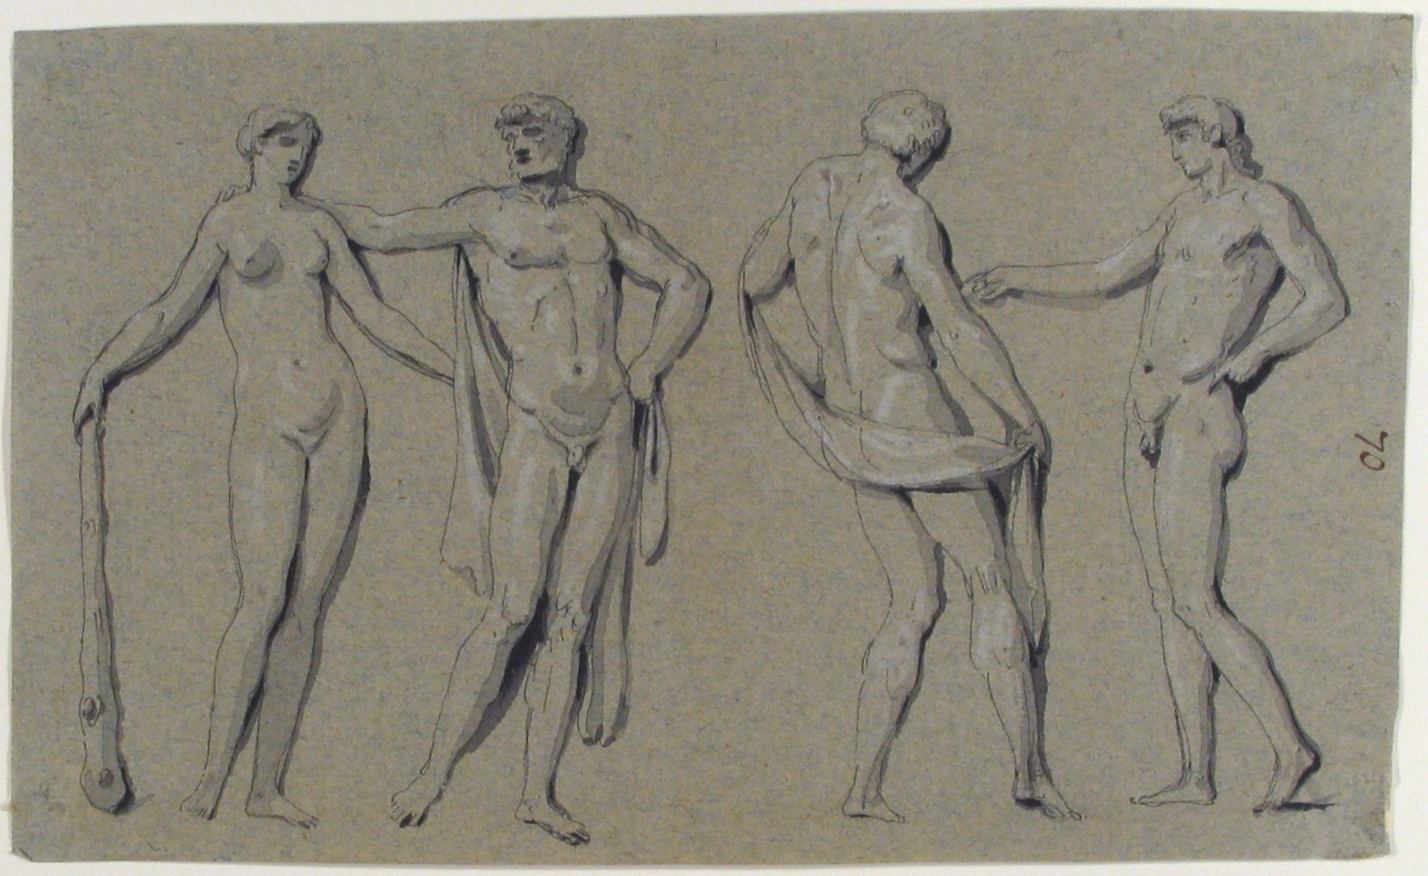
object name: drawing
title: Group of Nude Figures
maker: anonymous, french, 18th century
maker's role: artist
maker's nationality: french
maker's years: 1700-1800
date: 1701-1800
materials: ink, paper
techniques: brush, heightening, pen, wash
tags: male nudes,female nudes